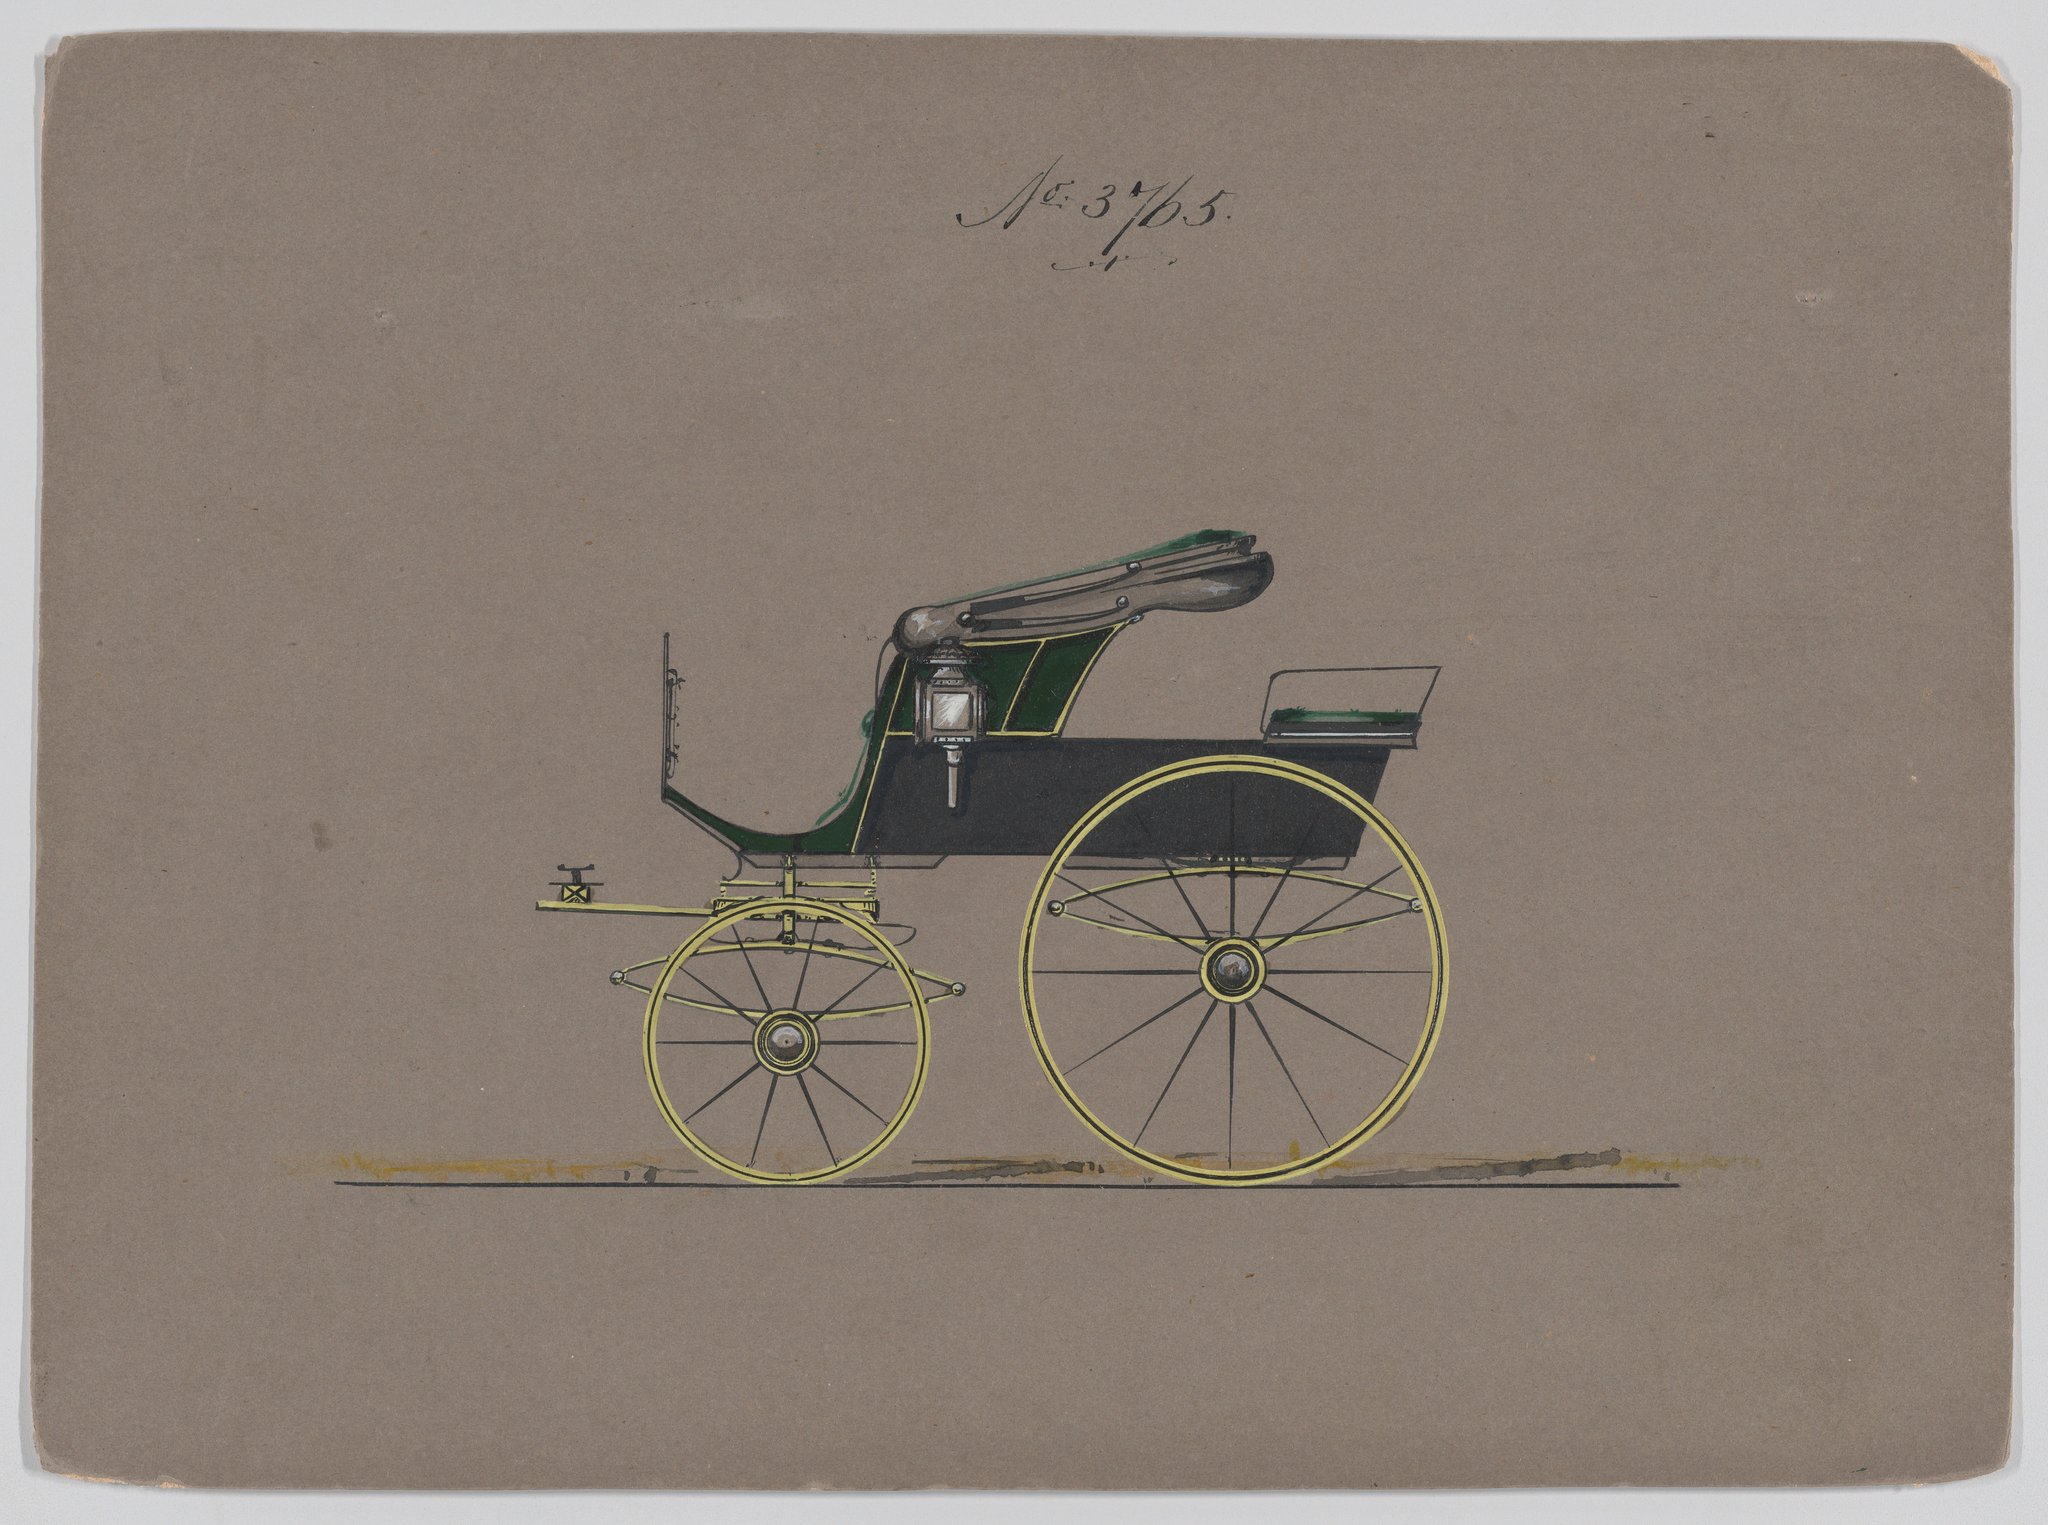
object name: drawing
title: Design for Stanhope Phaeton, no. 3765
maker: brewster & co.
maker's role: manufacturer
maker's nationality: american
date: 1882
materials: gouache, gum arabic, ink, watercolor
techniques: pen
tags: carriages